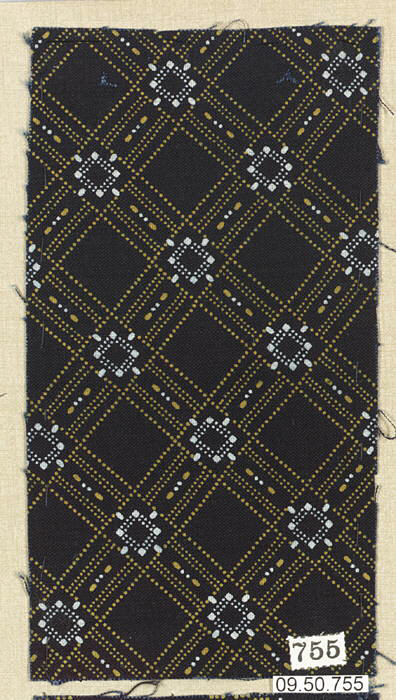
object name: piece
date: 1801-1900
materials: cotton